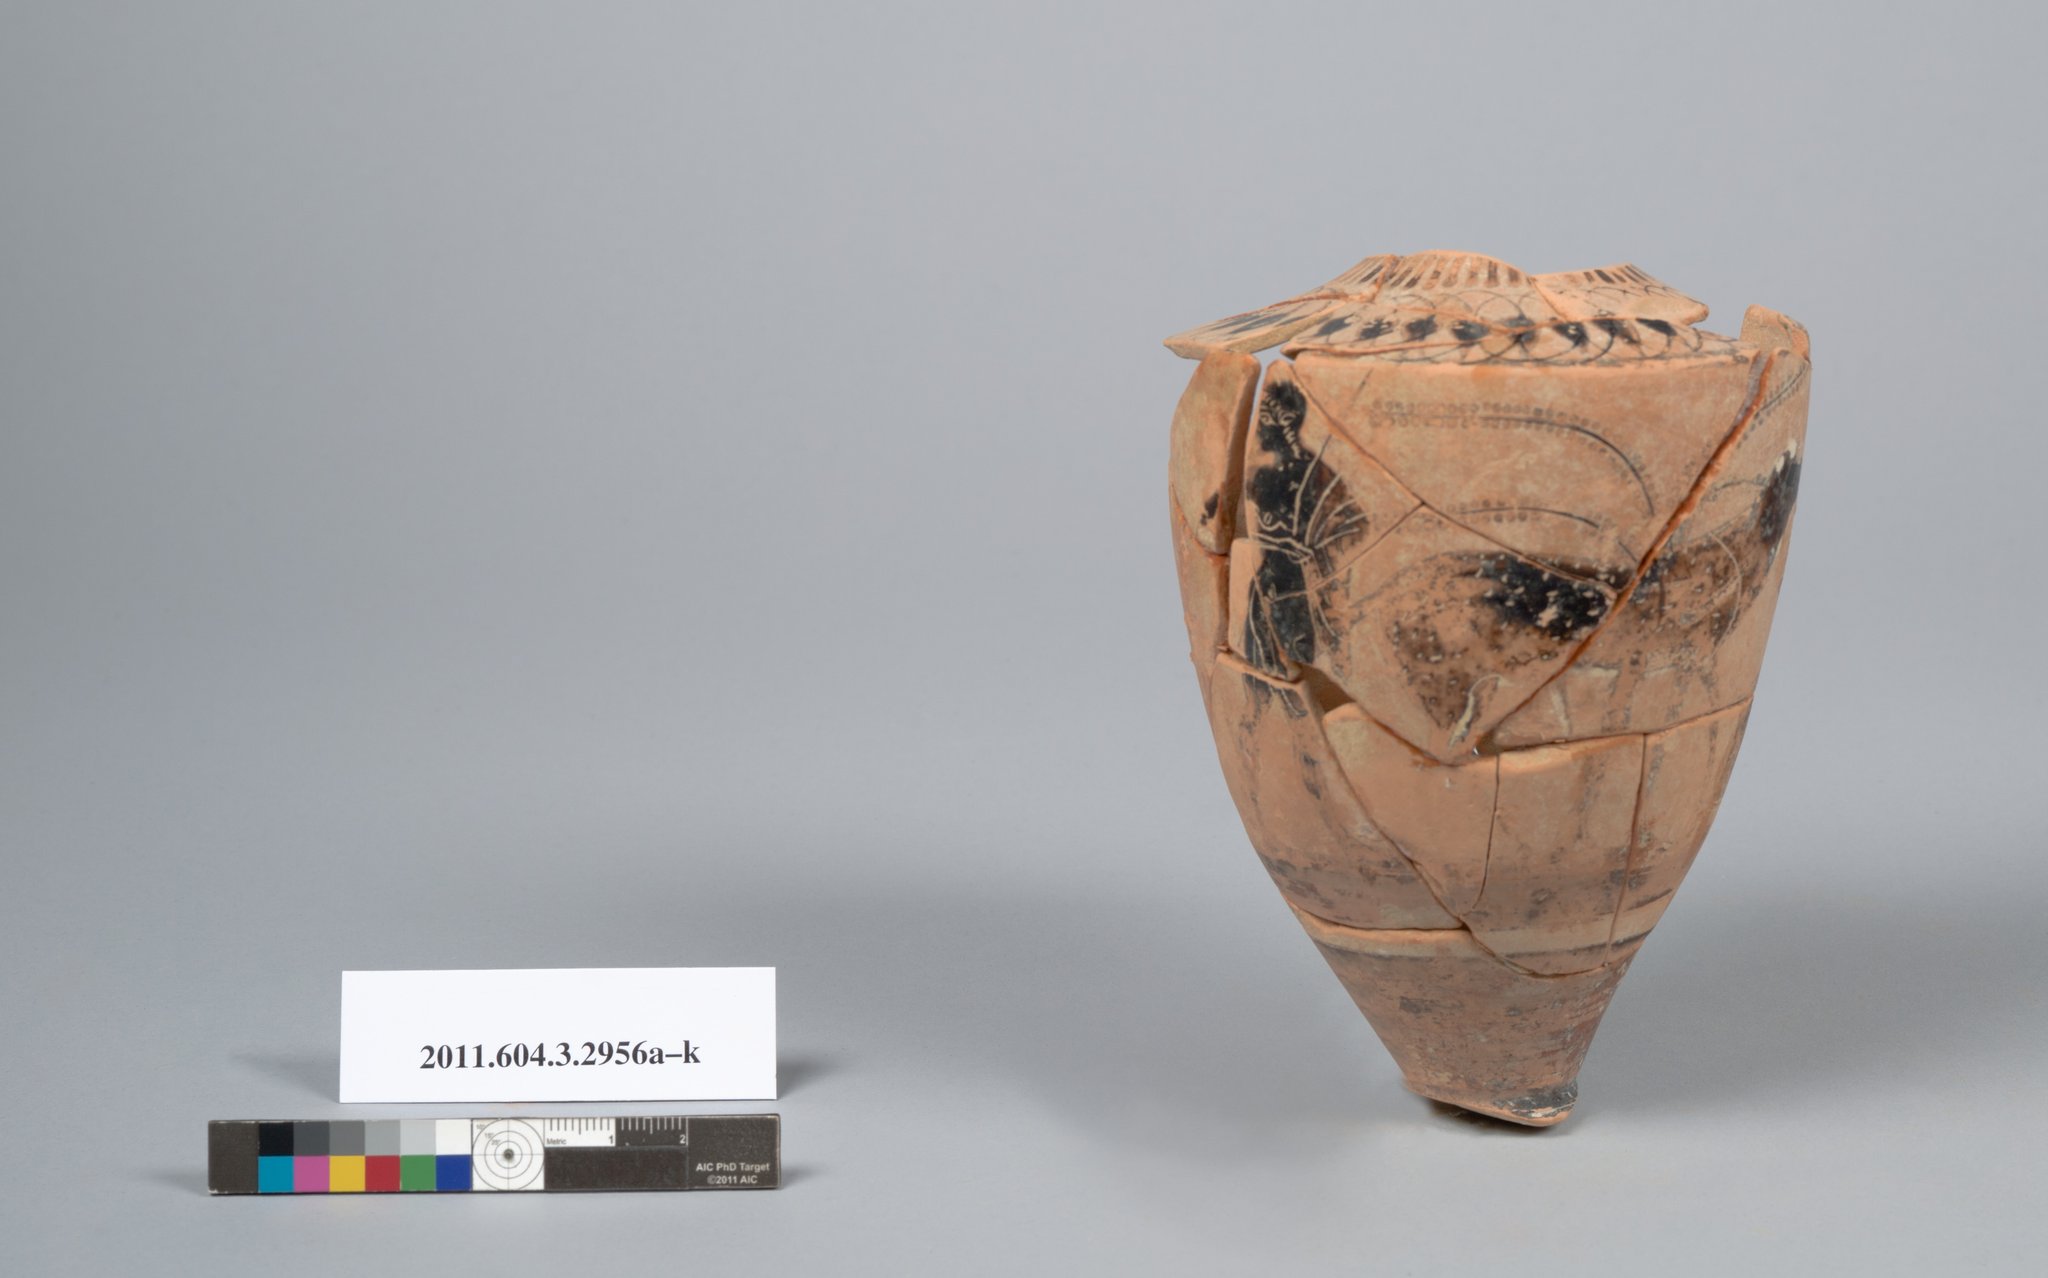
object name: lekythos fragment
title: Terracotta fragments of a lekythos (oil flask)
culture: greek, attic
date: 534-468 BCE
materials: terracotta